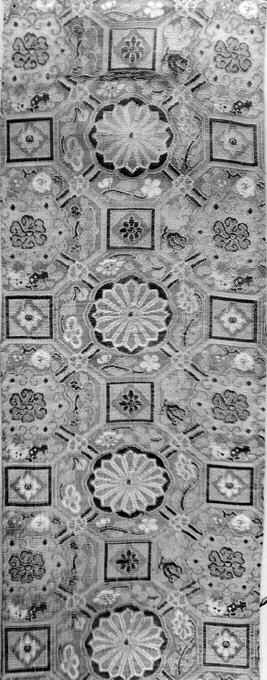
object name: piece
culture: chinese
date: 1867-1900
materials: silk